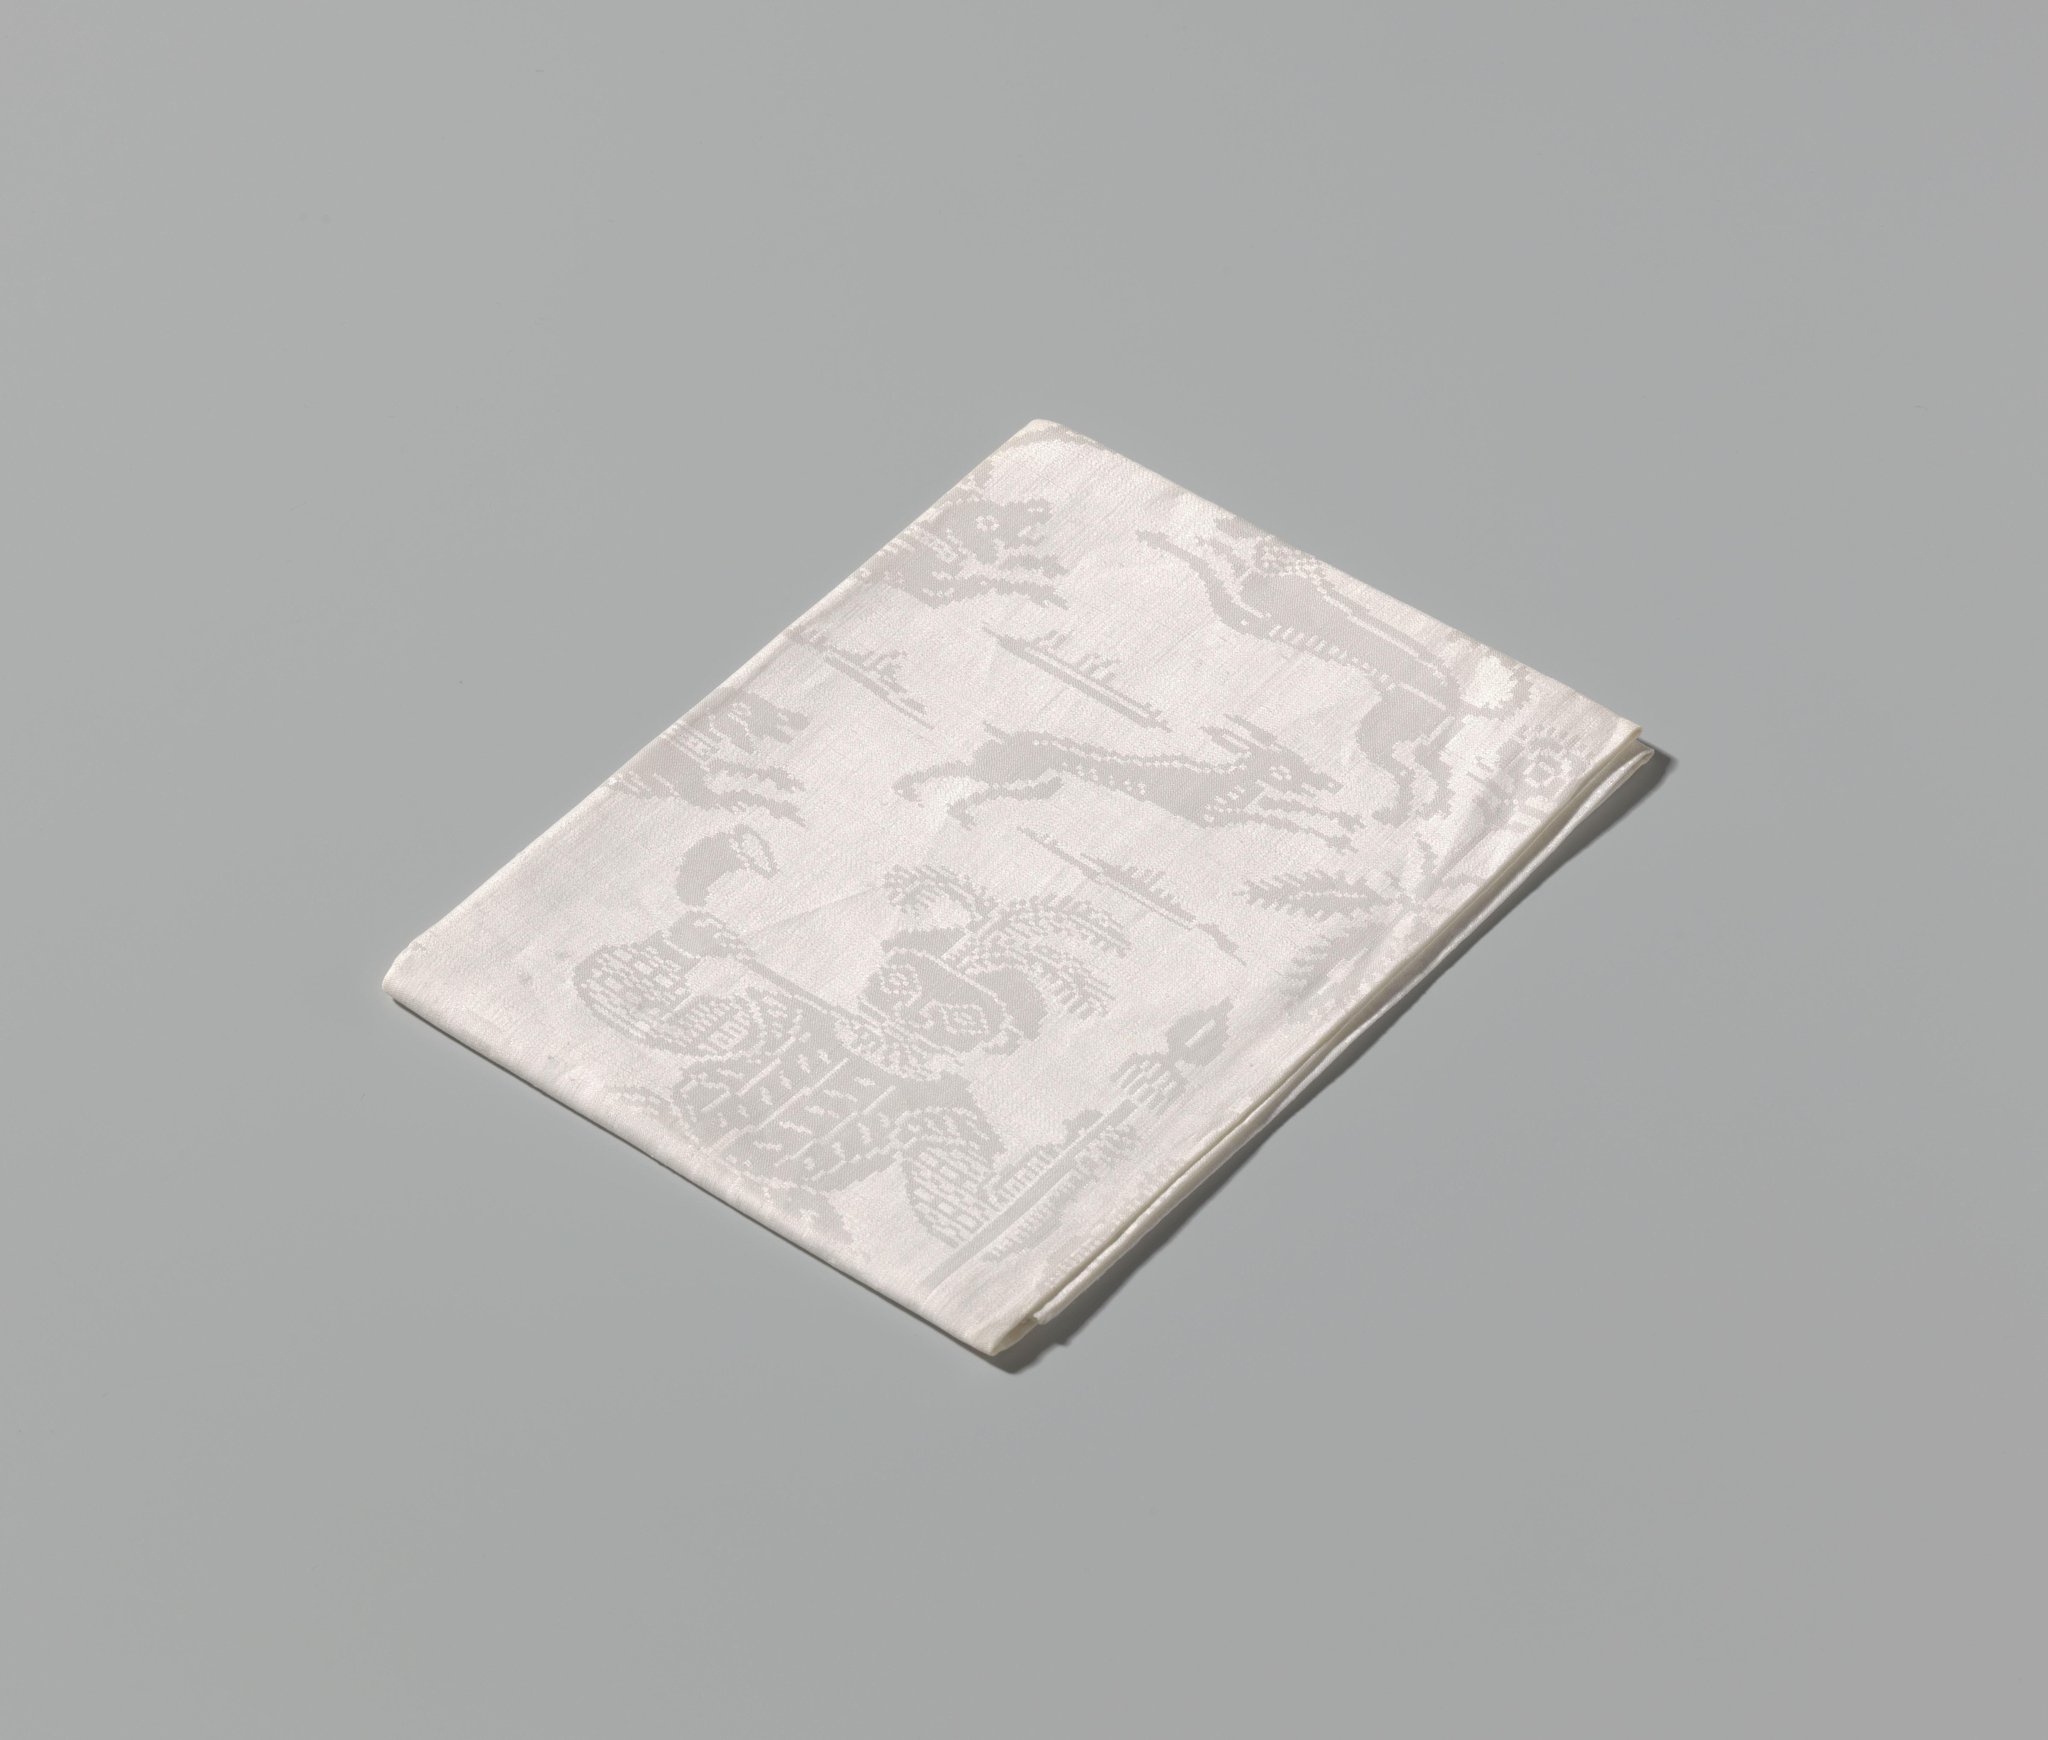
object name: napkin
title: Servet met valken- en hertenjacht.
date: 1625-1650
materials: linen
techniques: damask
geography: netherlands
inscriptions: mark: ‘VLS’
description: Wit linnen damasten servet met valke- en hertejacht.